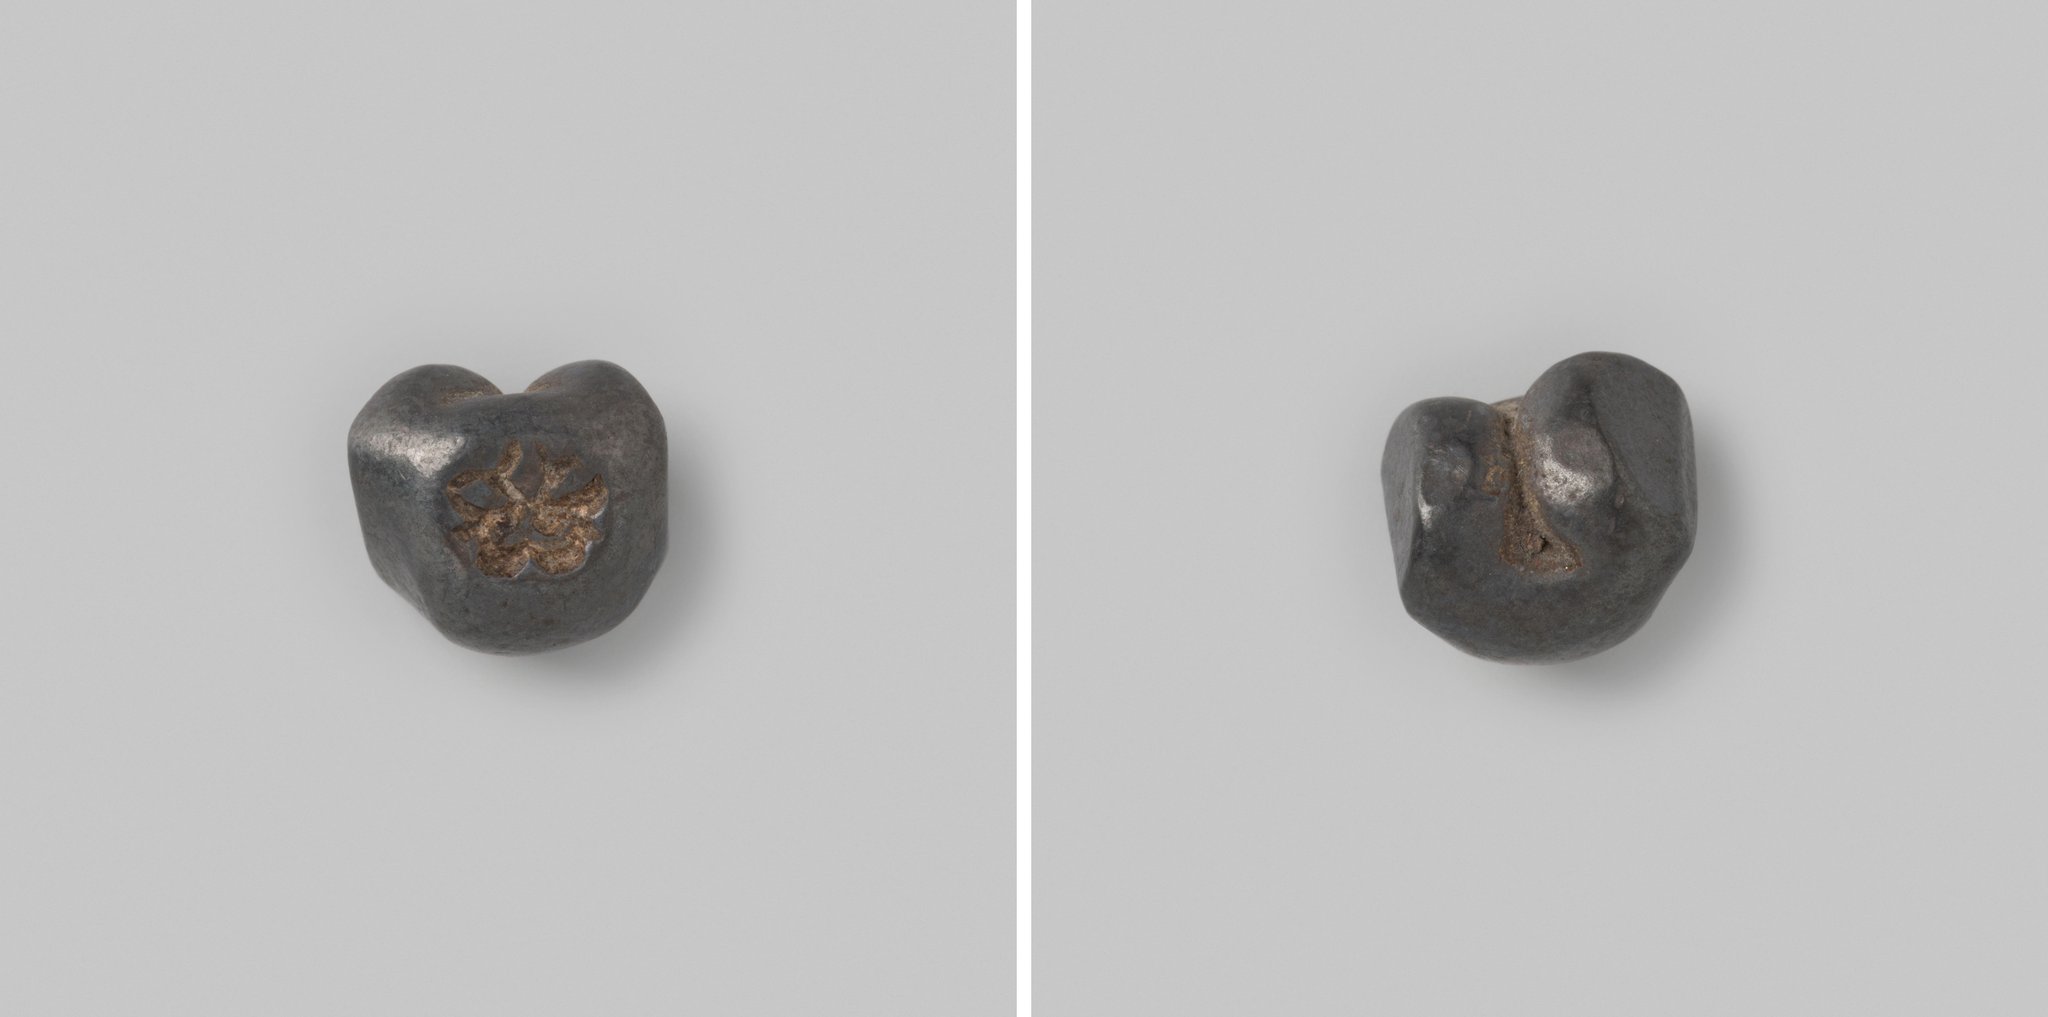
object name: coin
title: 1/4 tical of salung uit Thailand, 1650-1850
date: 1650-1850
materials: silver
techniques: casting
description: Zilveren, korrelvormige munt. voorzien van één instempeling (kra): lotusbloem